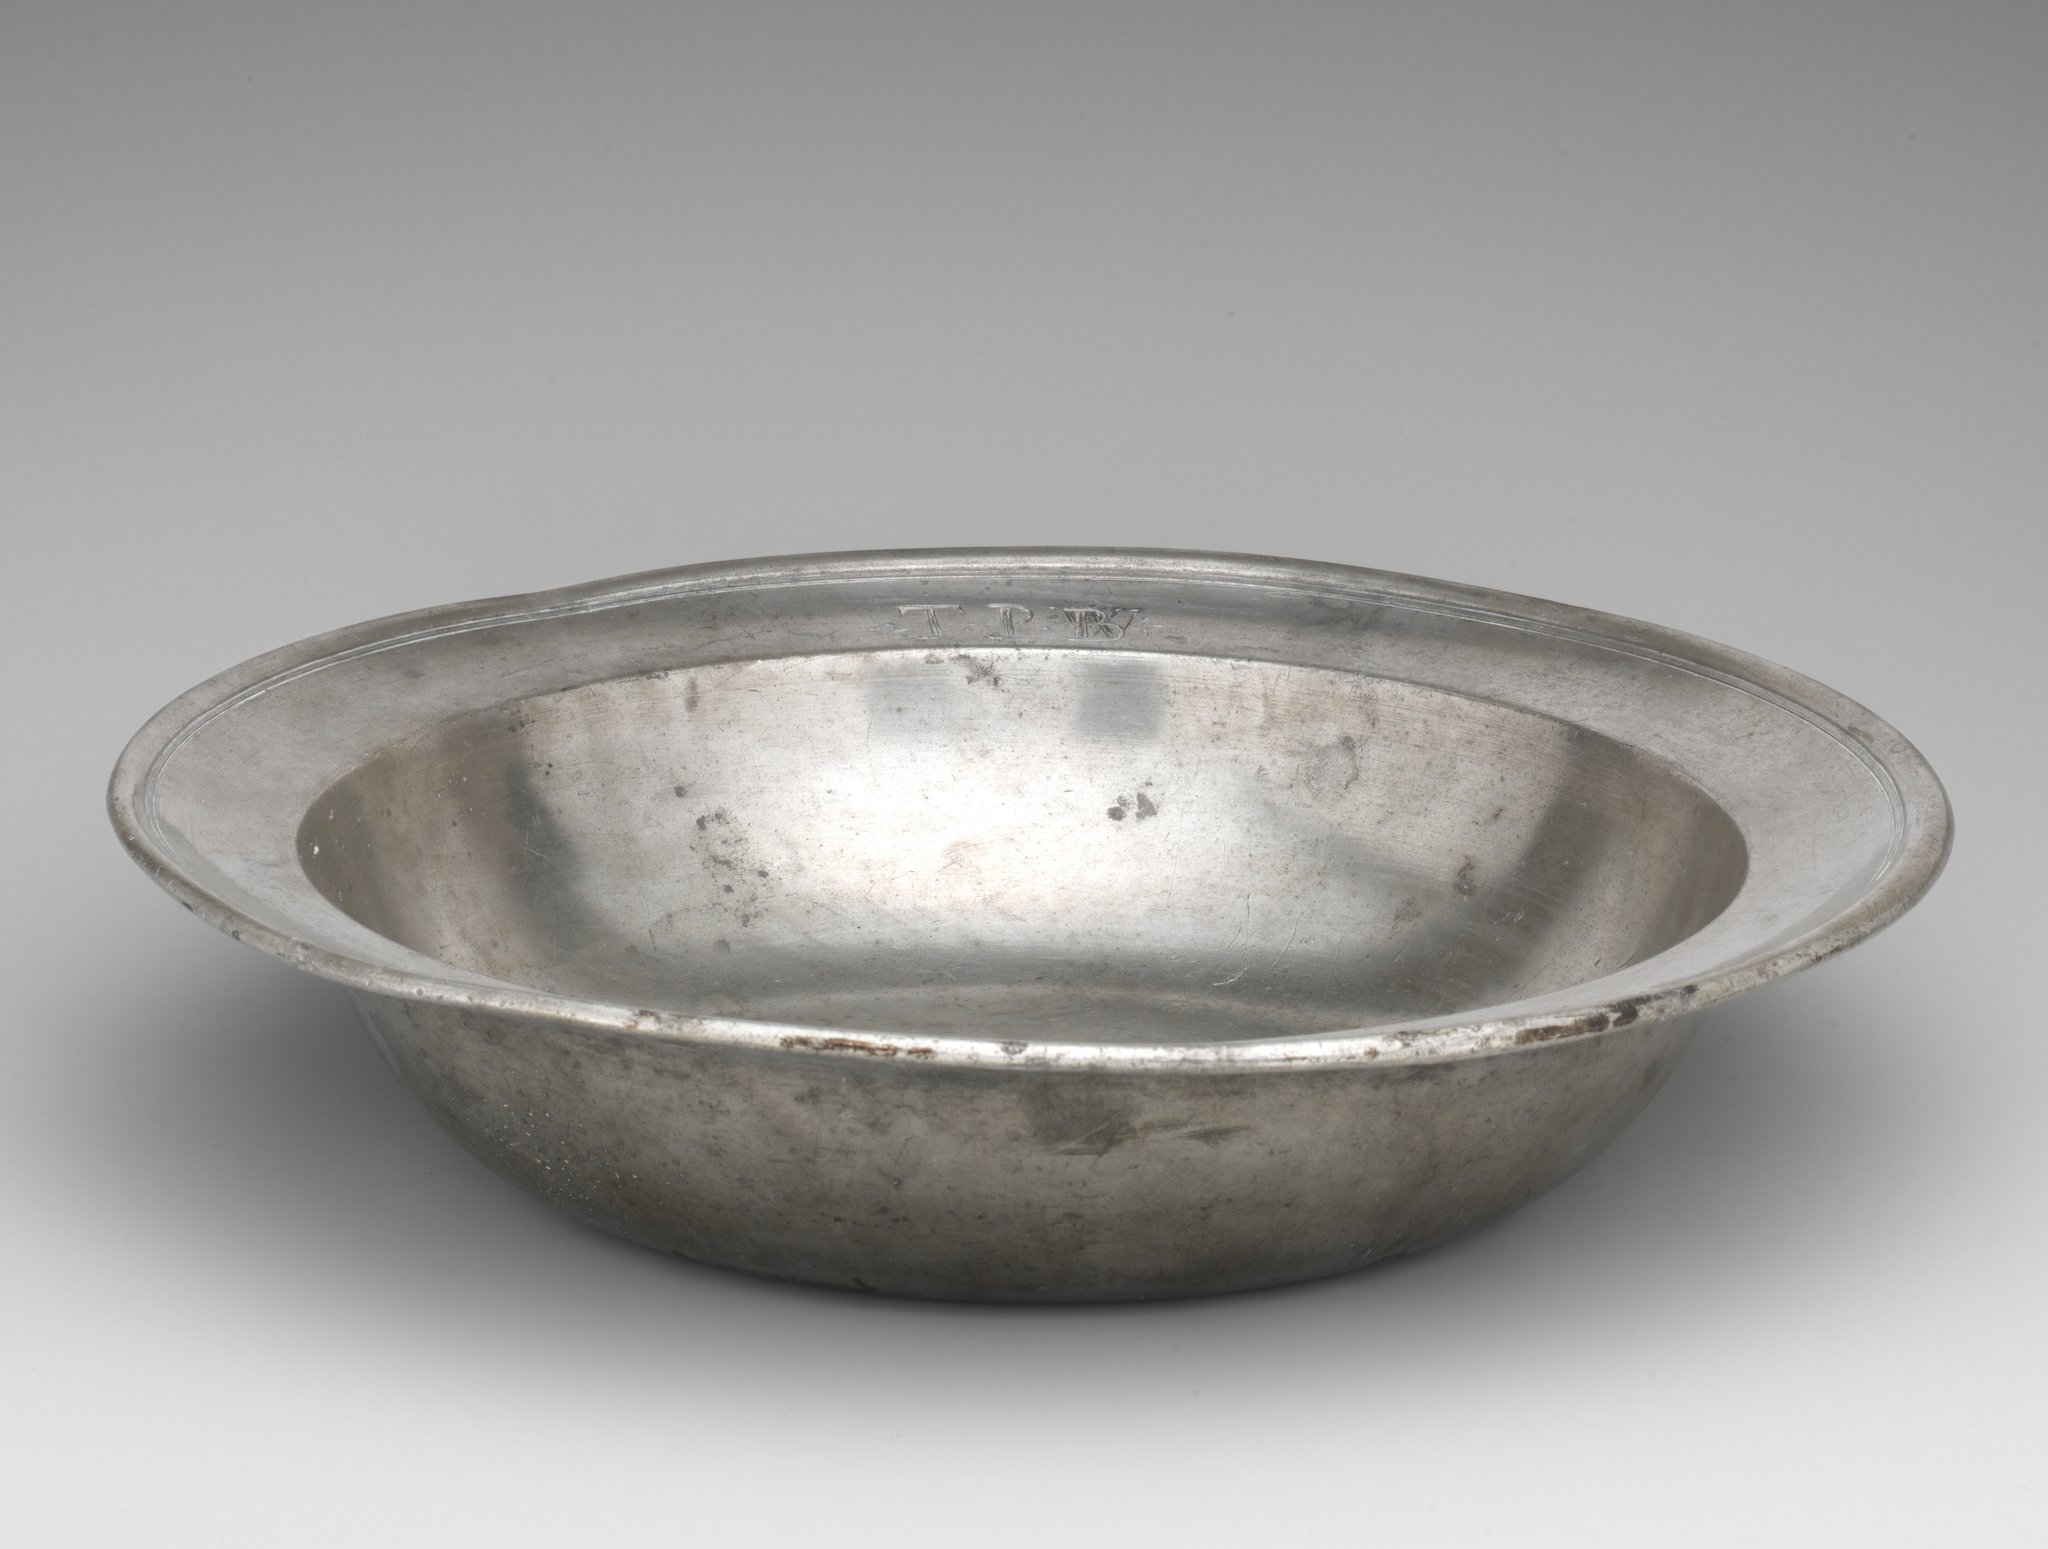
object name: bowl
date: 1751-1800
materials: pewter